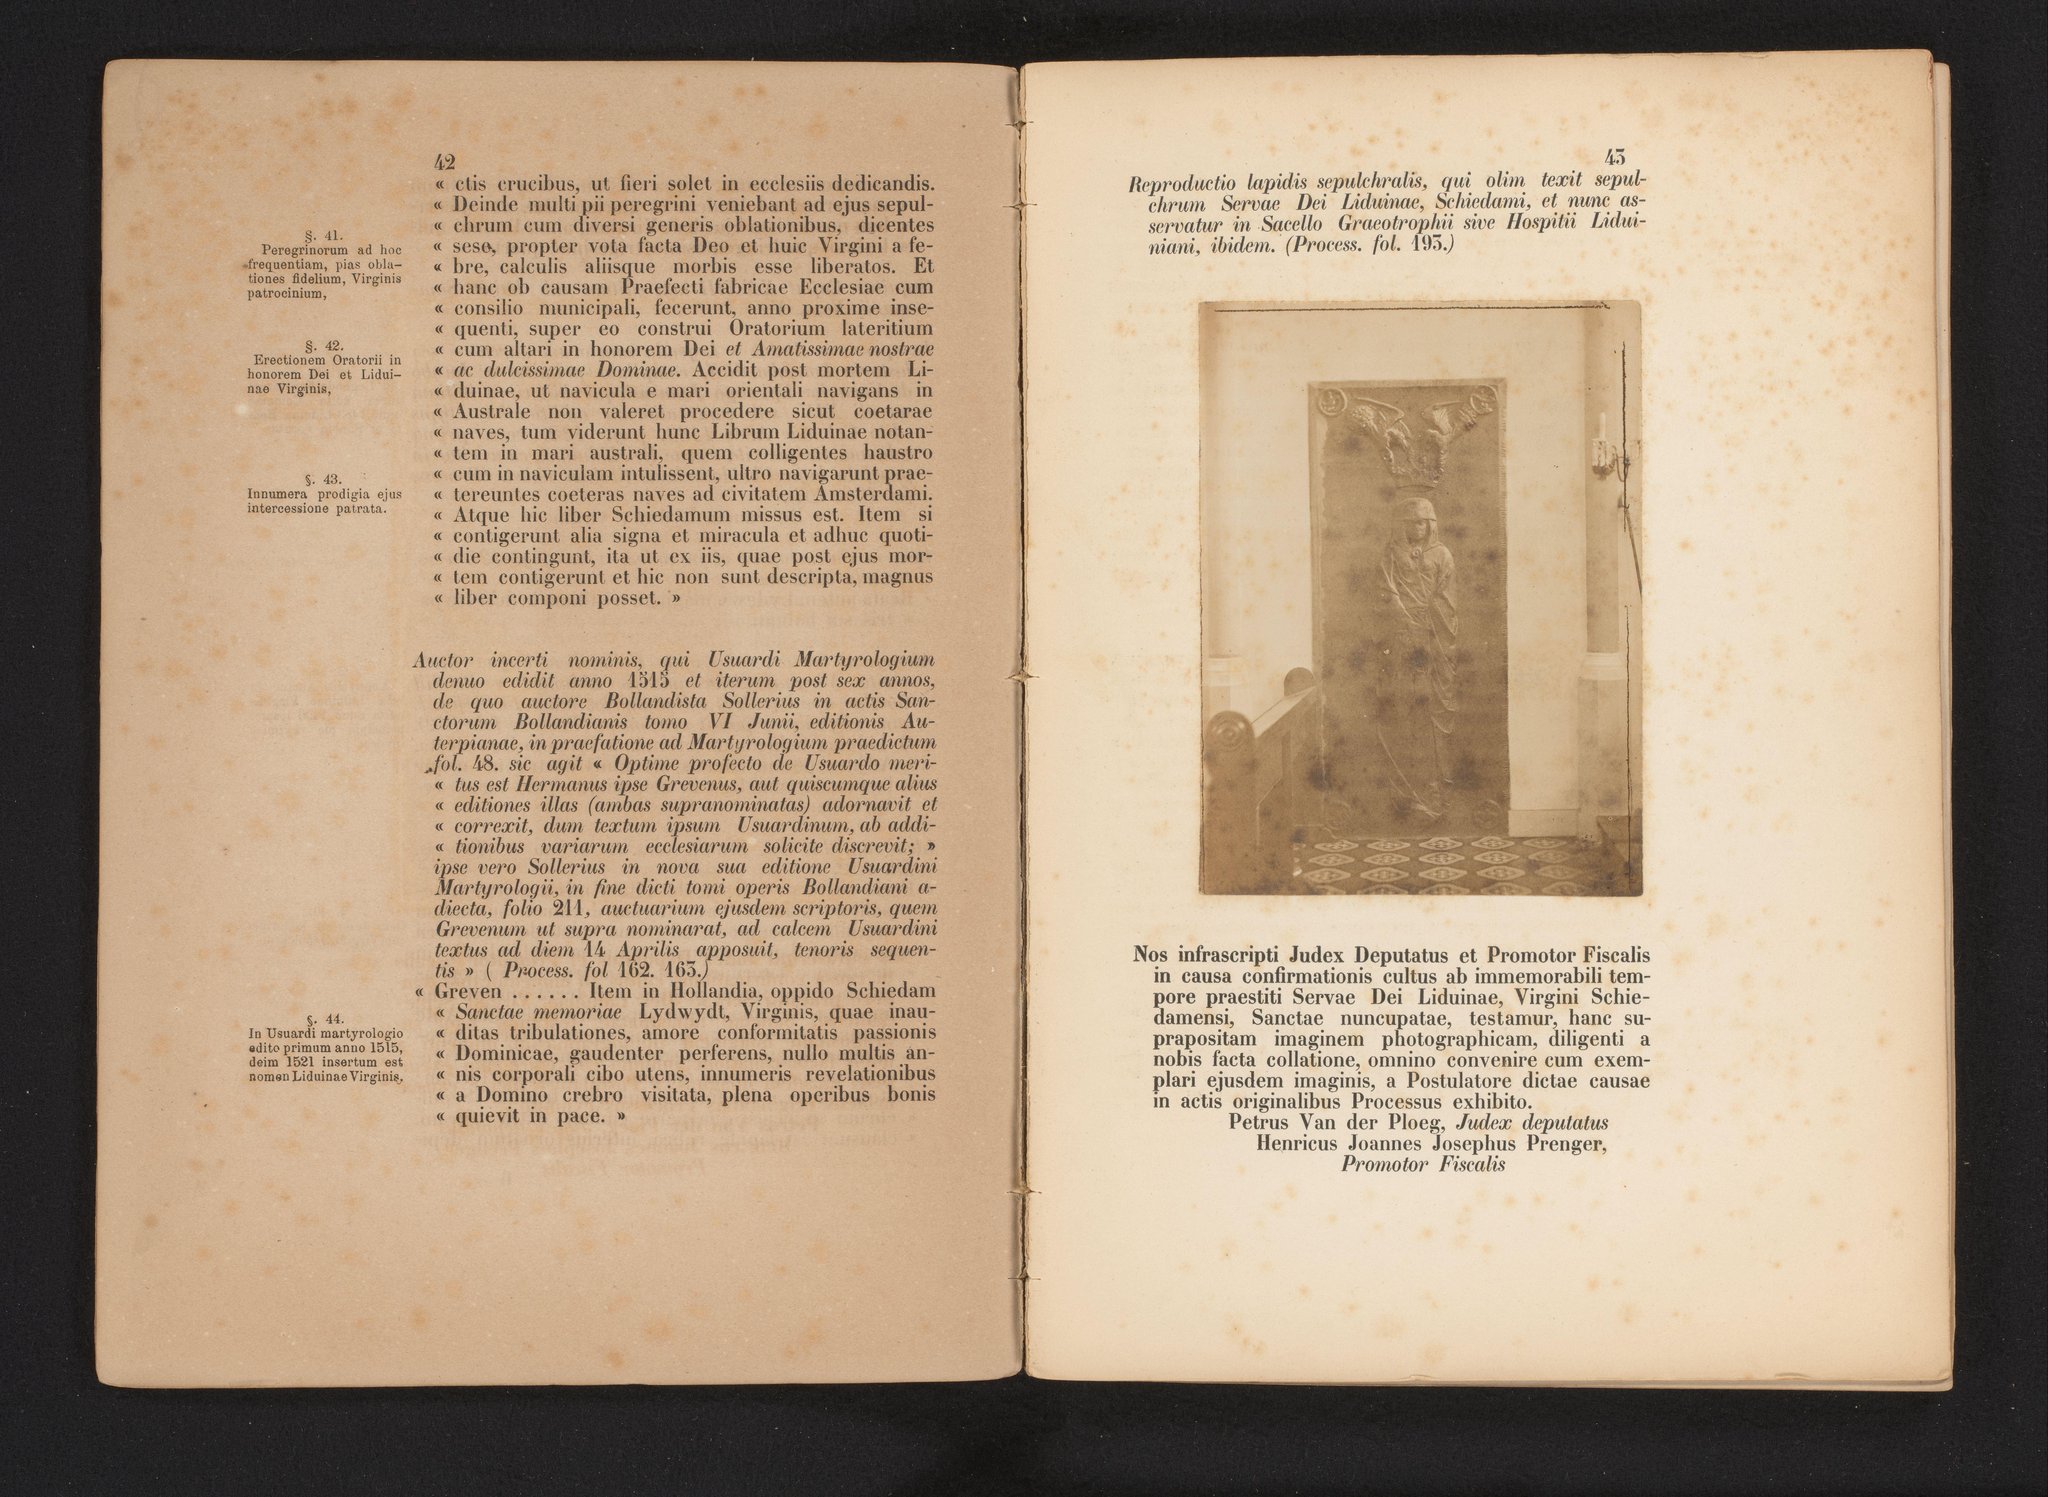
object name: page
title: Grafsteen van Liduina van Schiedam in de Sint-Liduinakerk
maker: Anonymous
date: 1859-1877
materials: paper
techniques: albumen print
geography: schiedam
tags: gravestone, tombstone